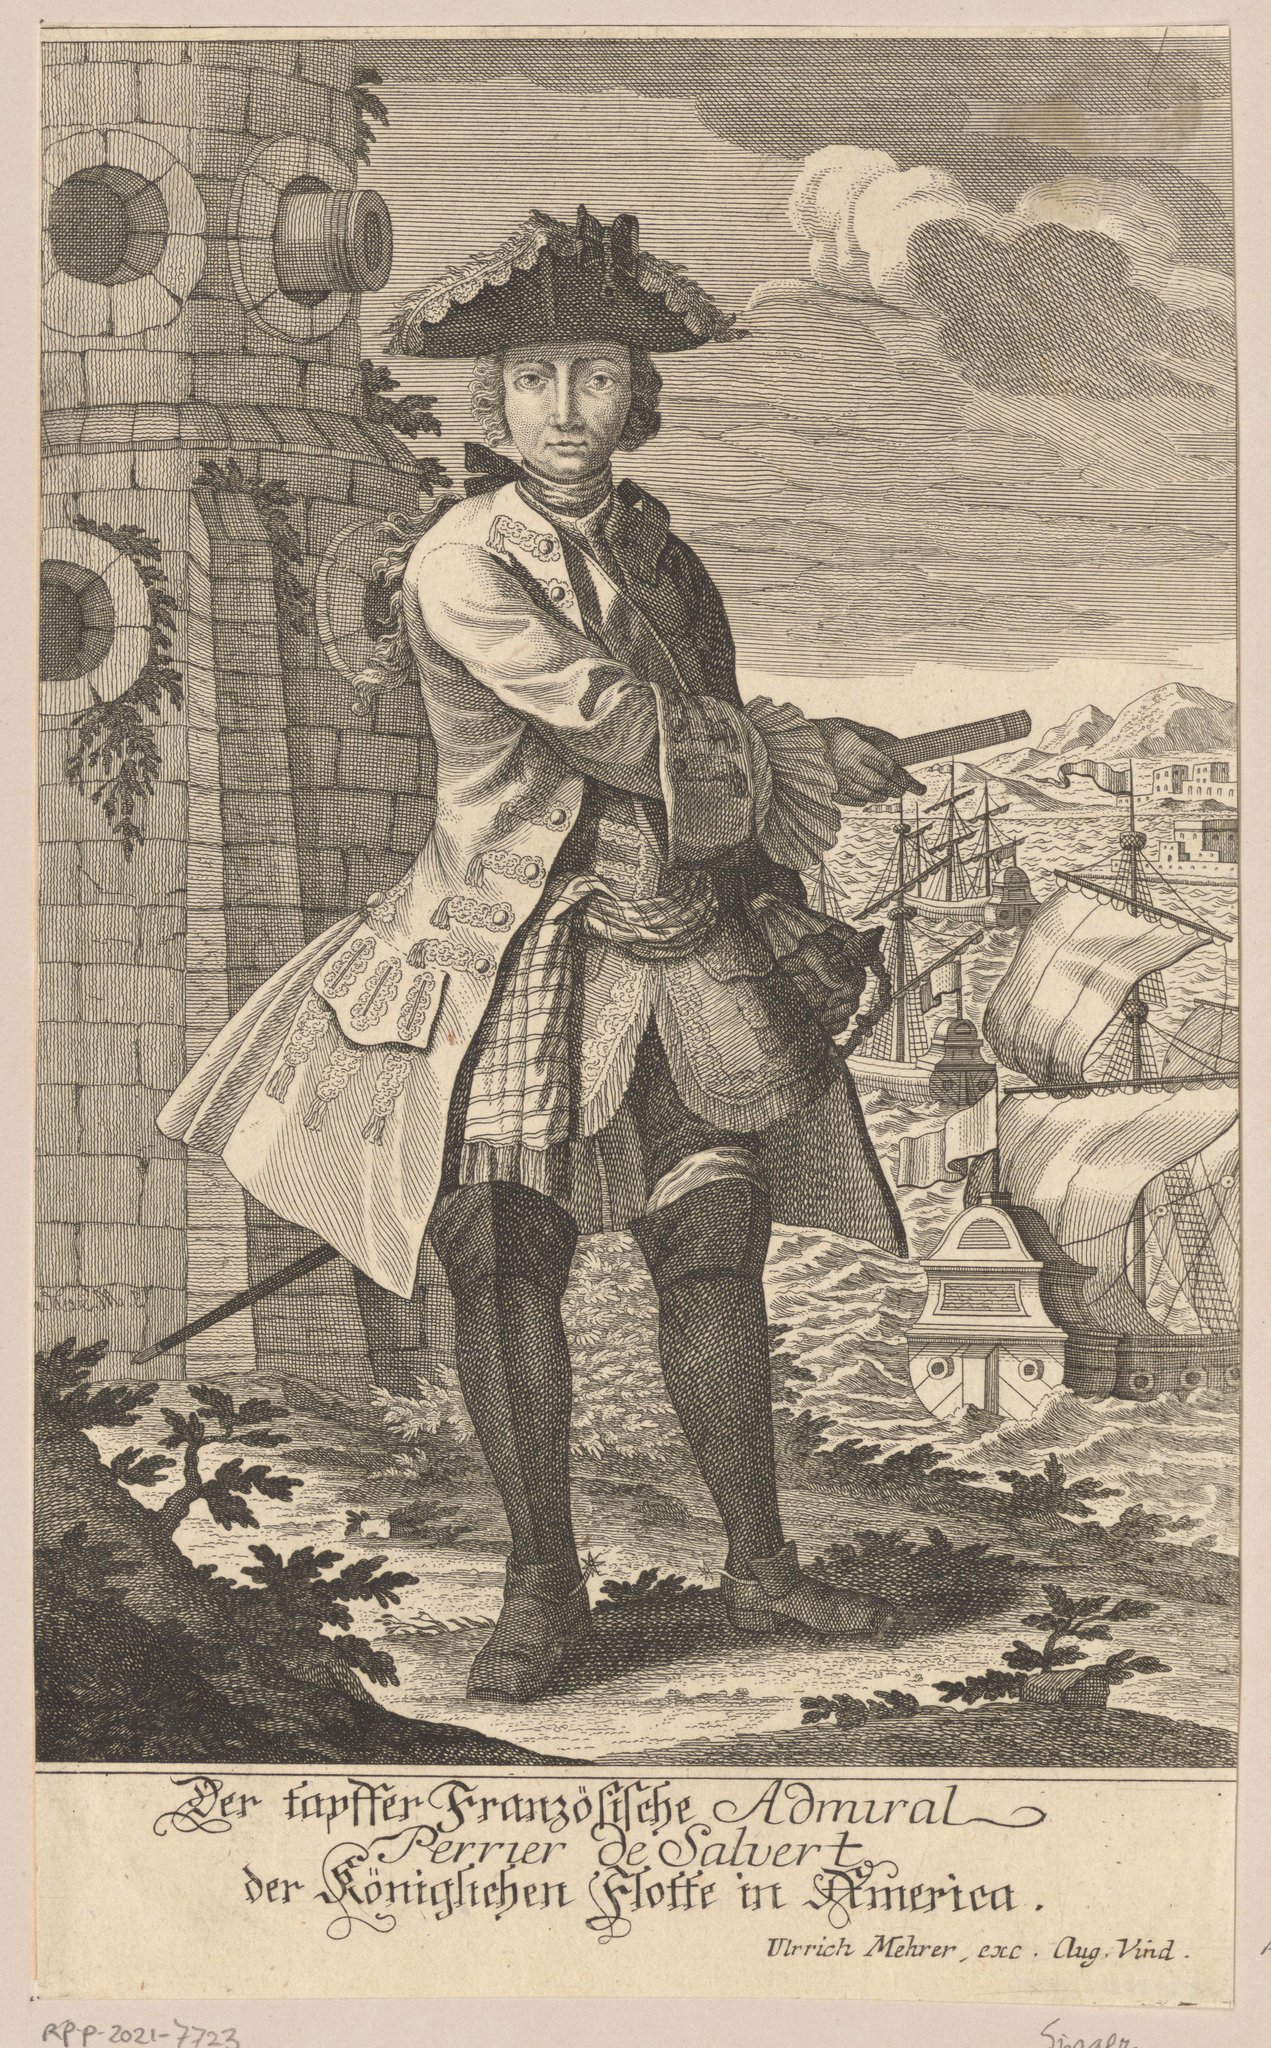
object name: print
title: Portret van Antoine Alexis de Perier de Salvert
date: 1710-1799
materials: paper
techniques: engraving, etching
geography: augsburg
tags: historical persons, ships (in general), officer